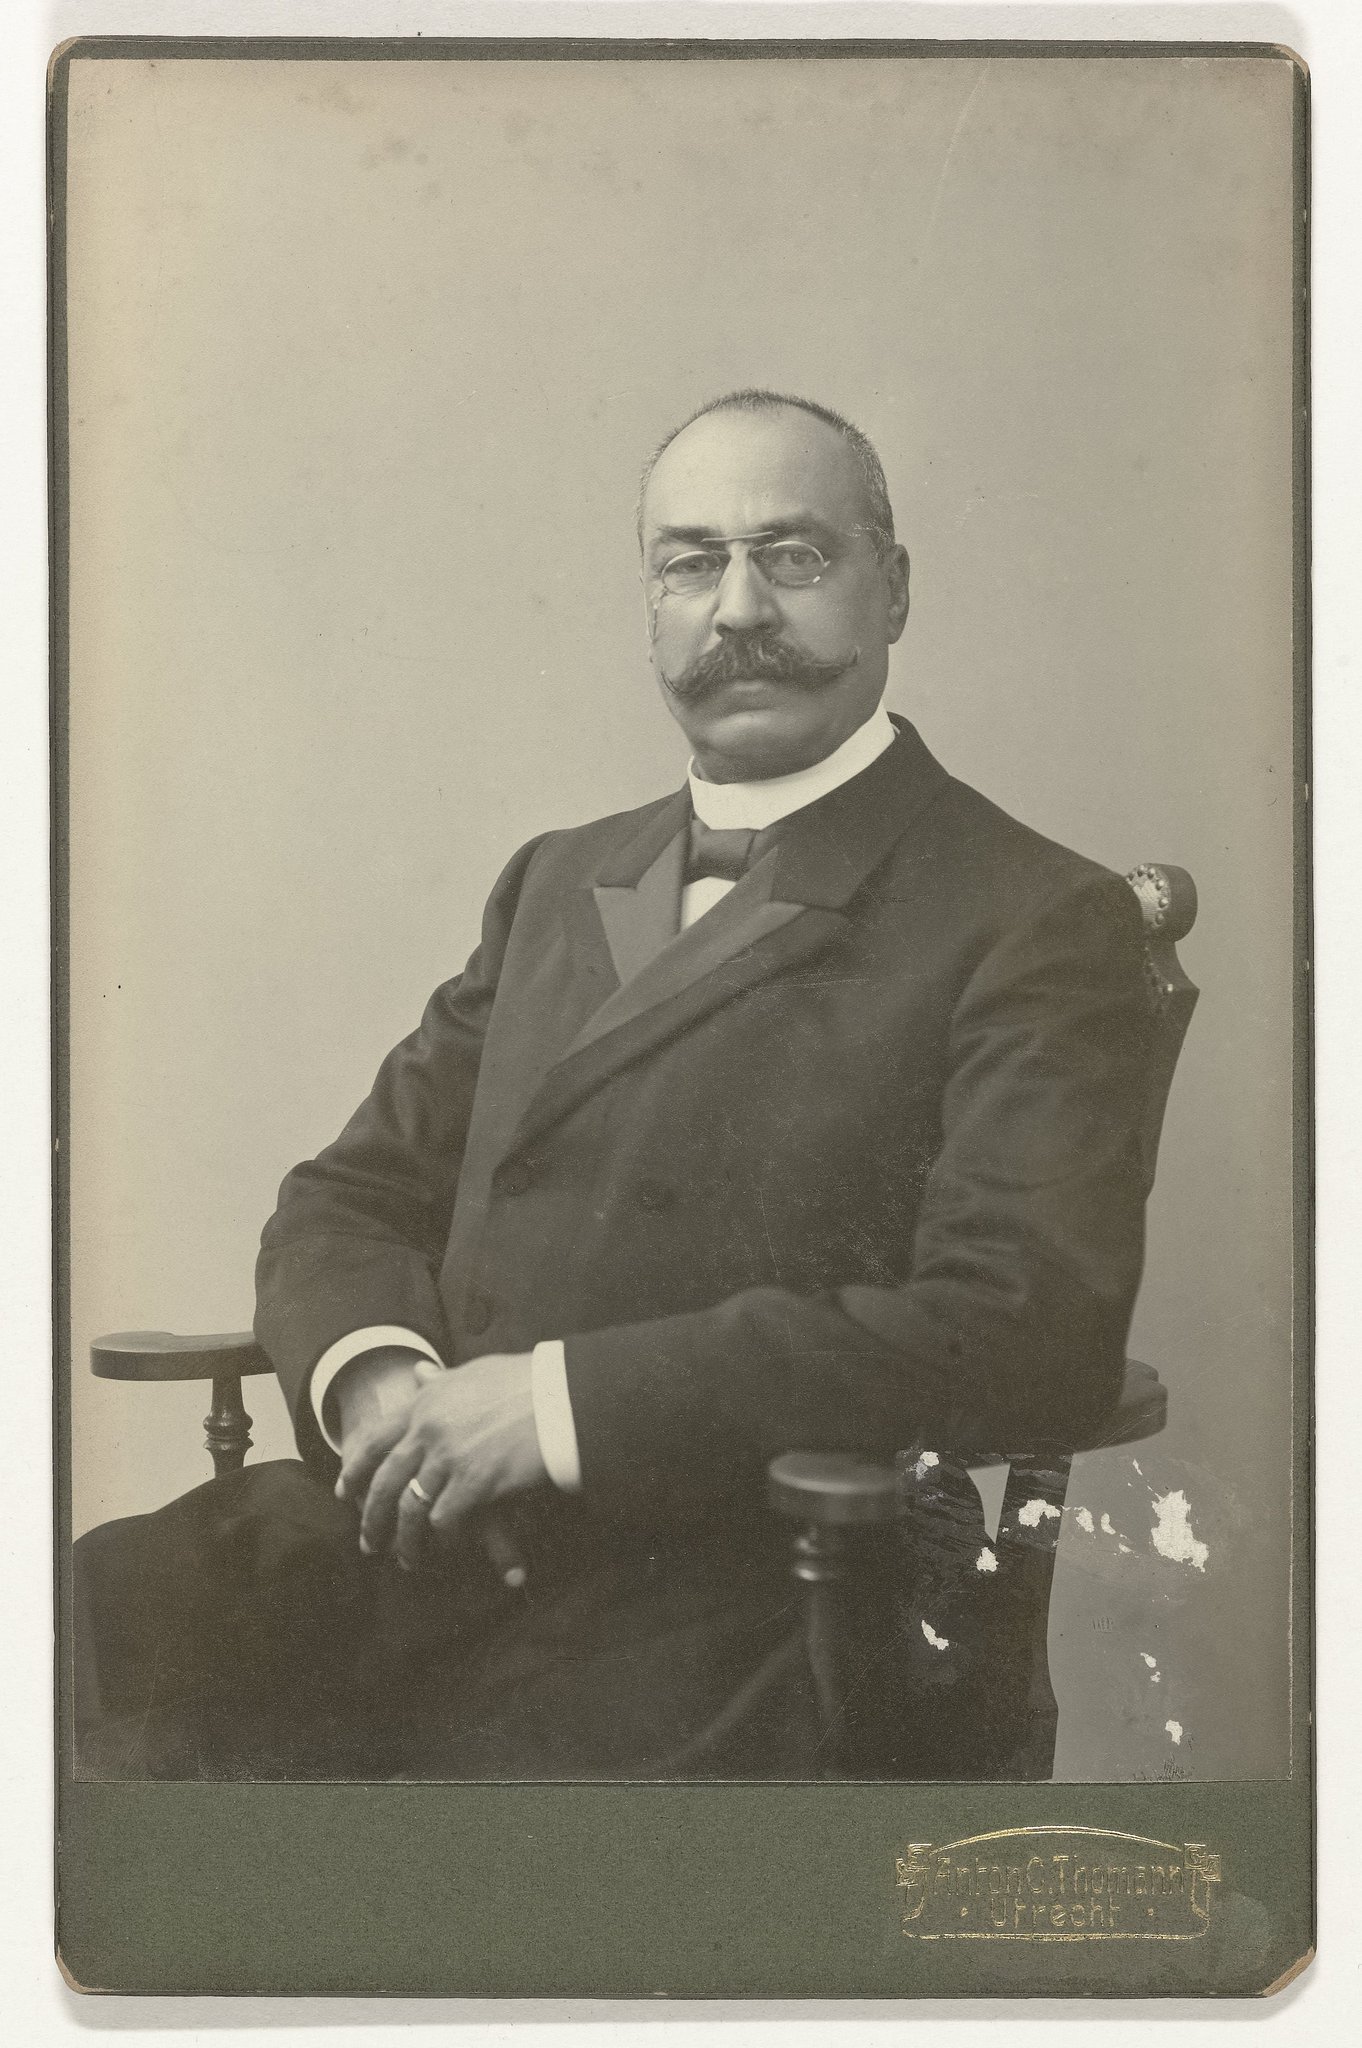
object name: cabinet photograph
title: Portret van Jacob Evert Wesenhagen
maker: anton cornelis thomann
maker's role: fotograaf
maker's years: 1873-1946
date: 1910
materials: cardboard, photographic support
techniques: photography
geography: utrecht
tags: jacob evert wesenhagen, suriname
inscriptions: annotation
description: Portret van de arts Jacob Evert Wesenhagen, zittend in een stoel. Onderdeel van een groep objecten afkomstig van de familie Wesenhagen in Suriname.